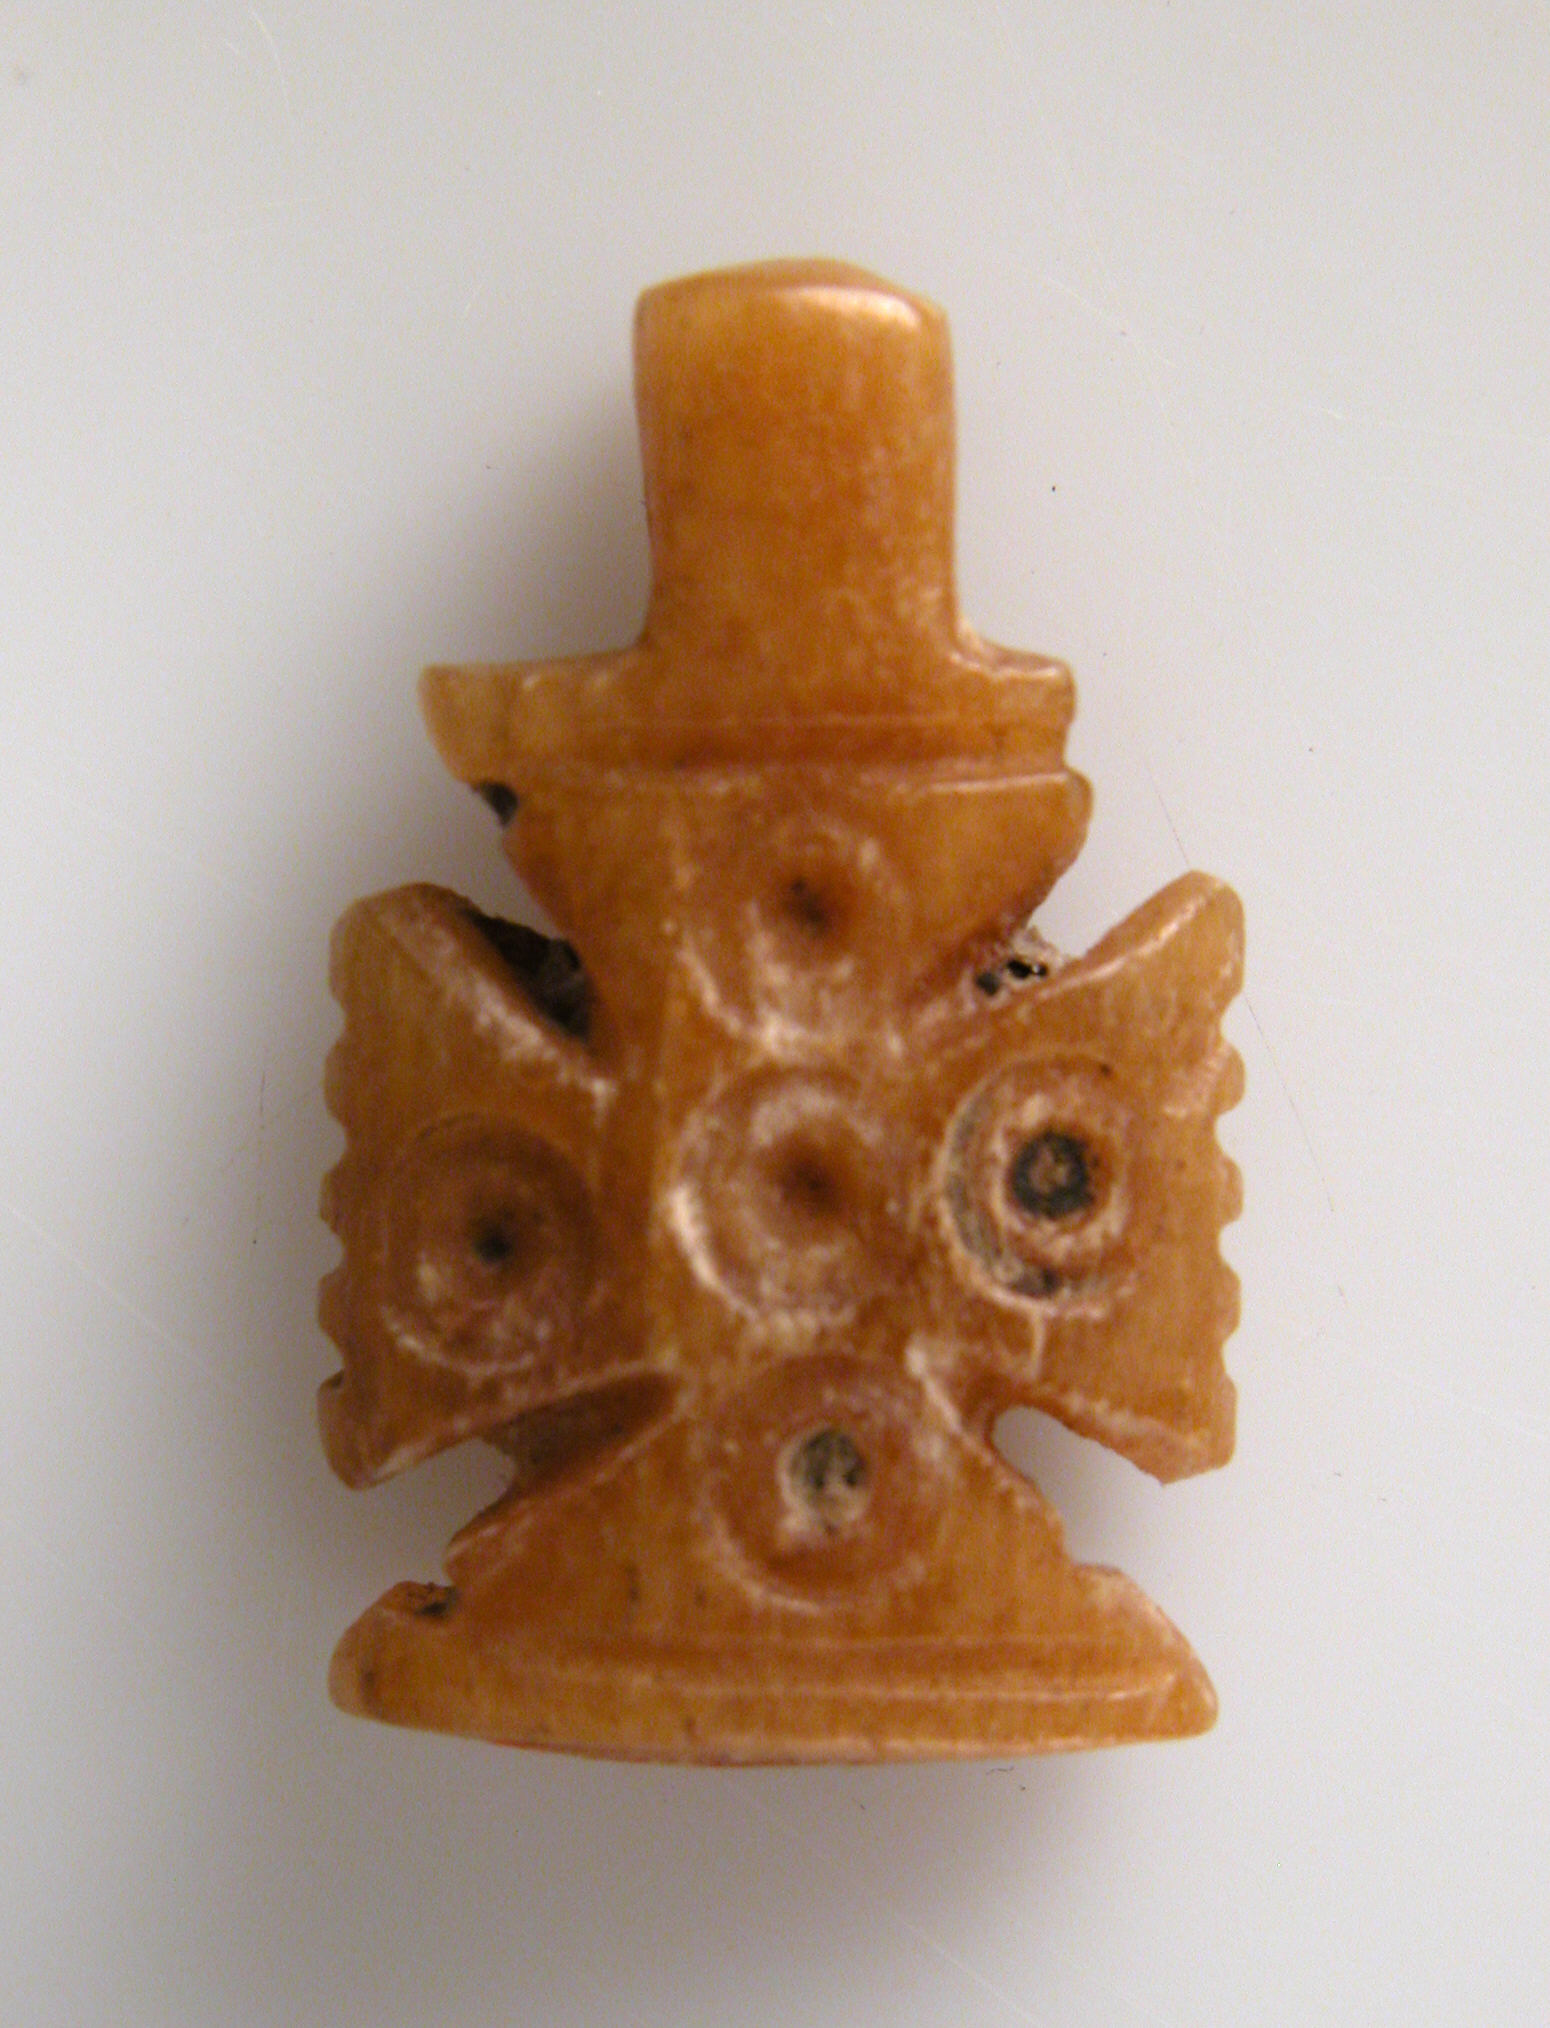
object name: pendant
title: Pendant Cross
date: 401-700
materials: bone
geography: egypt